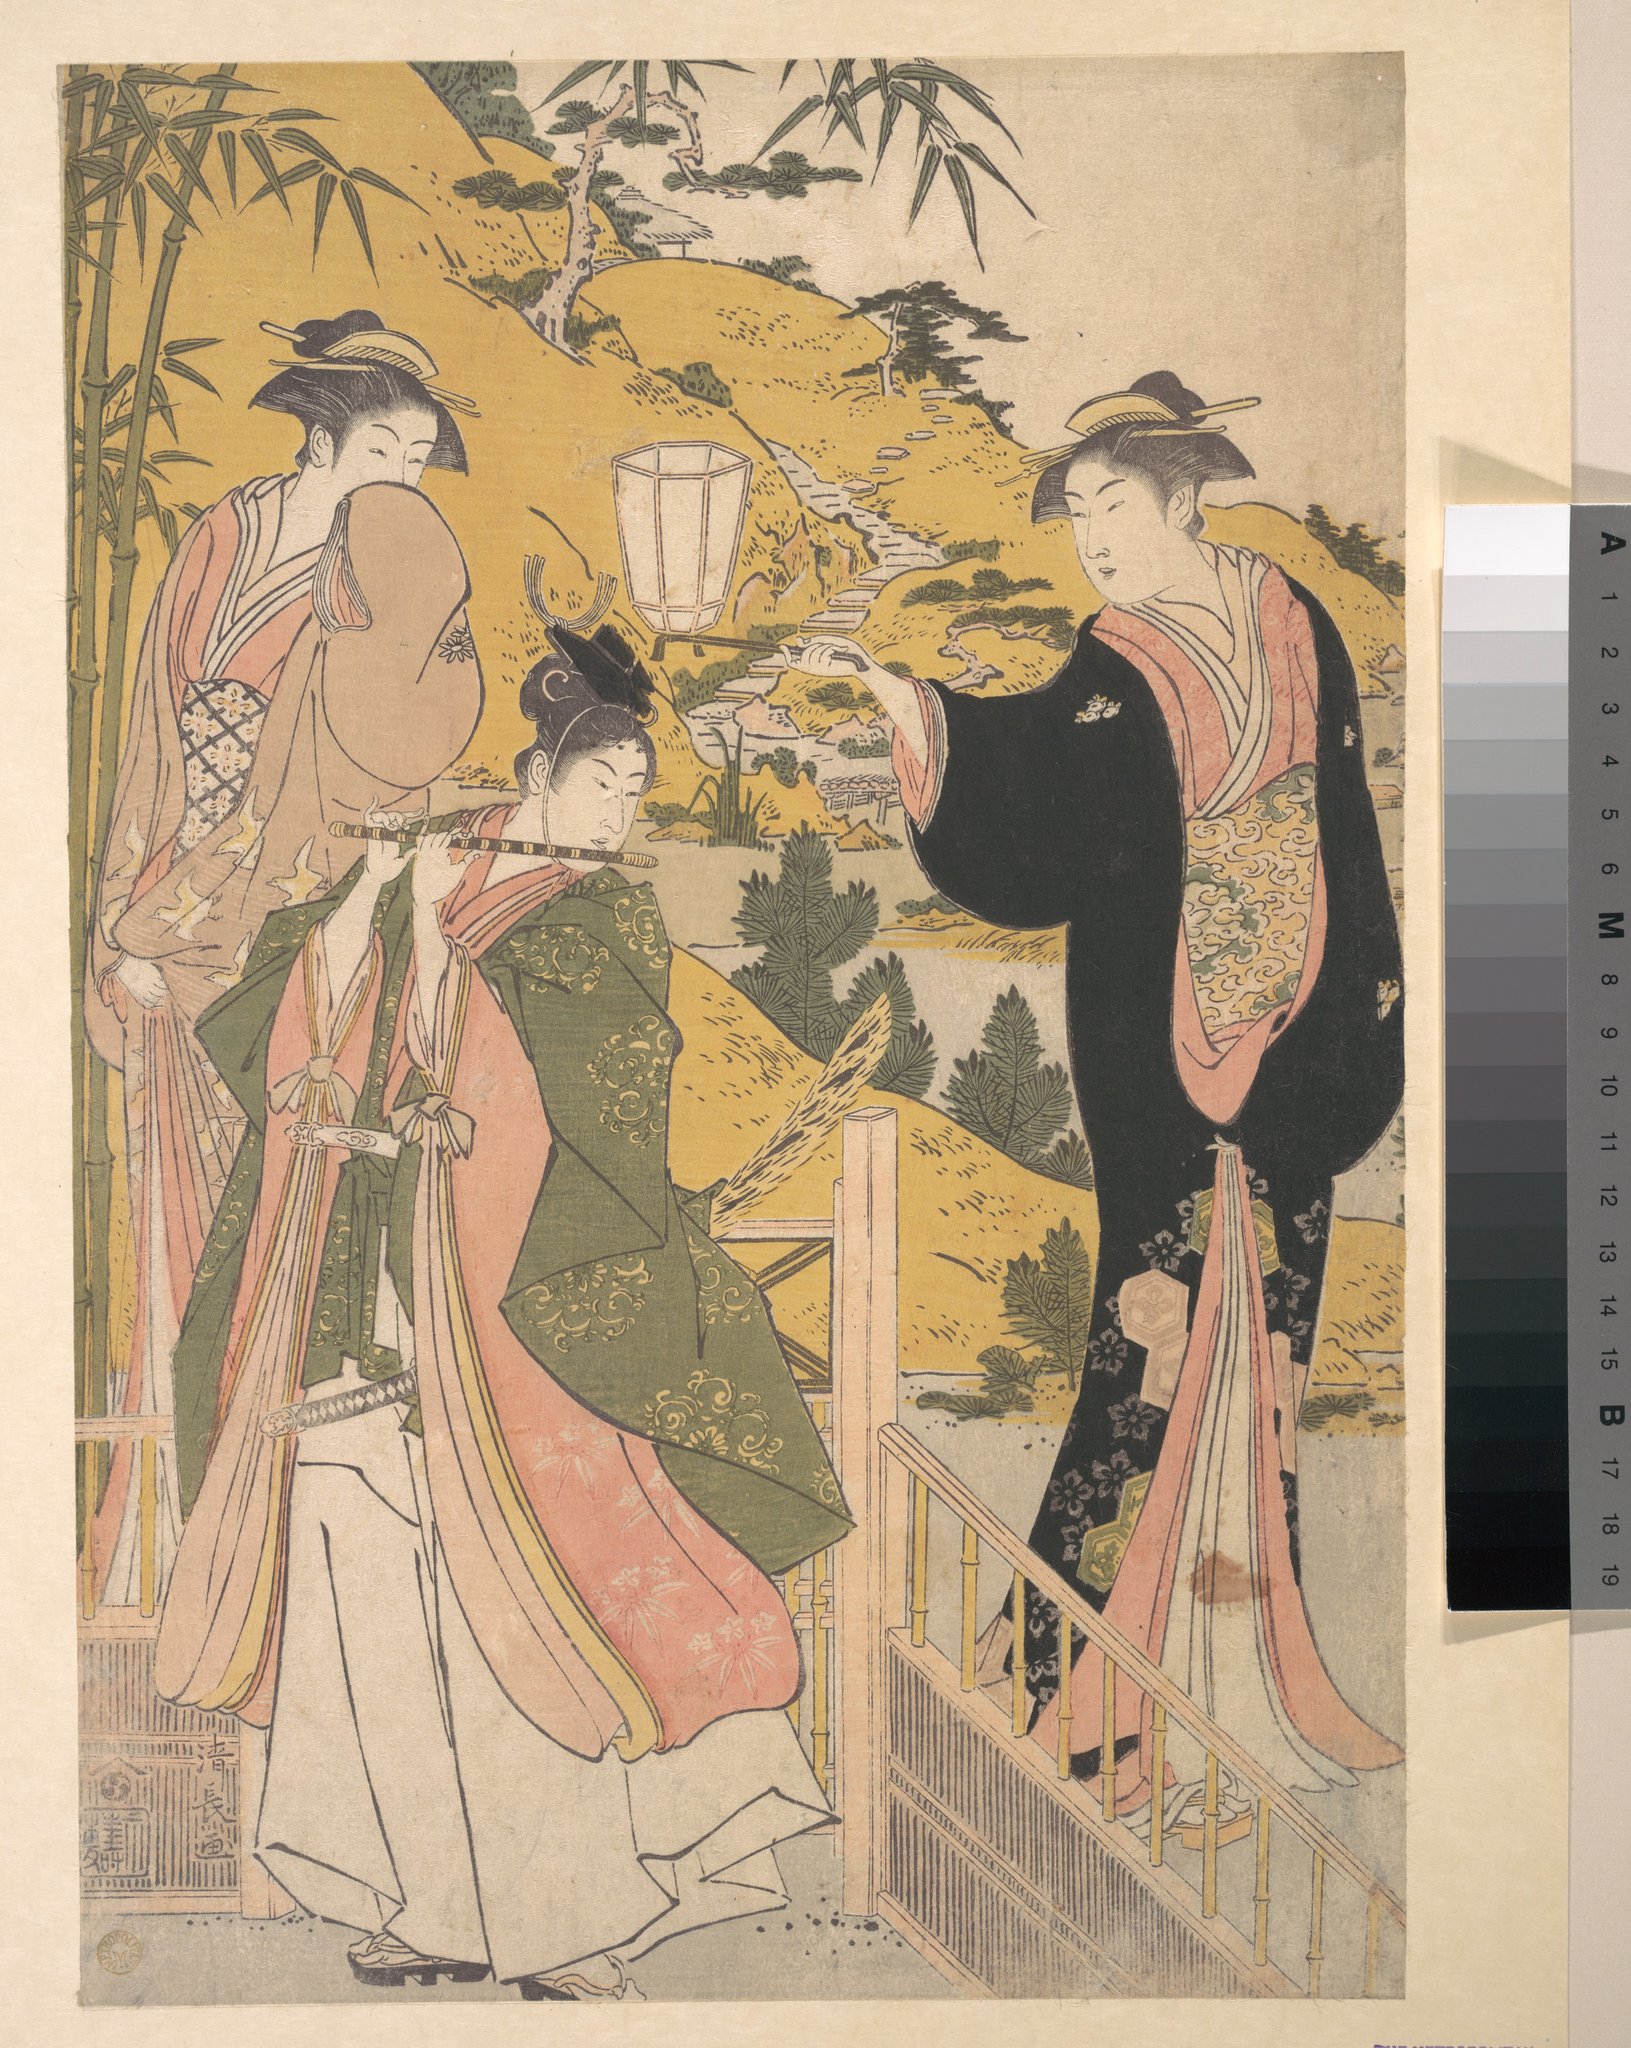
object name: print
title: Yoshitsune Serenading Jorurihime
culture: japanese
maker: torii kiyonaga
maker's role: artist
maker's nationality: japanese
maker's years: 1752-1815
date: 1785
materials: ink, paper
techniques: woodblock print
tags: men,women,flutes